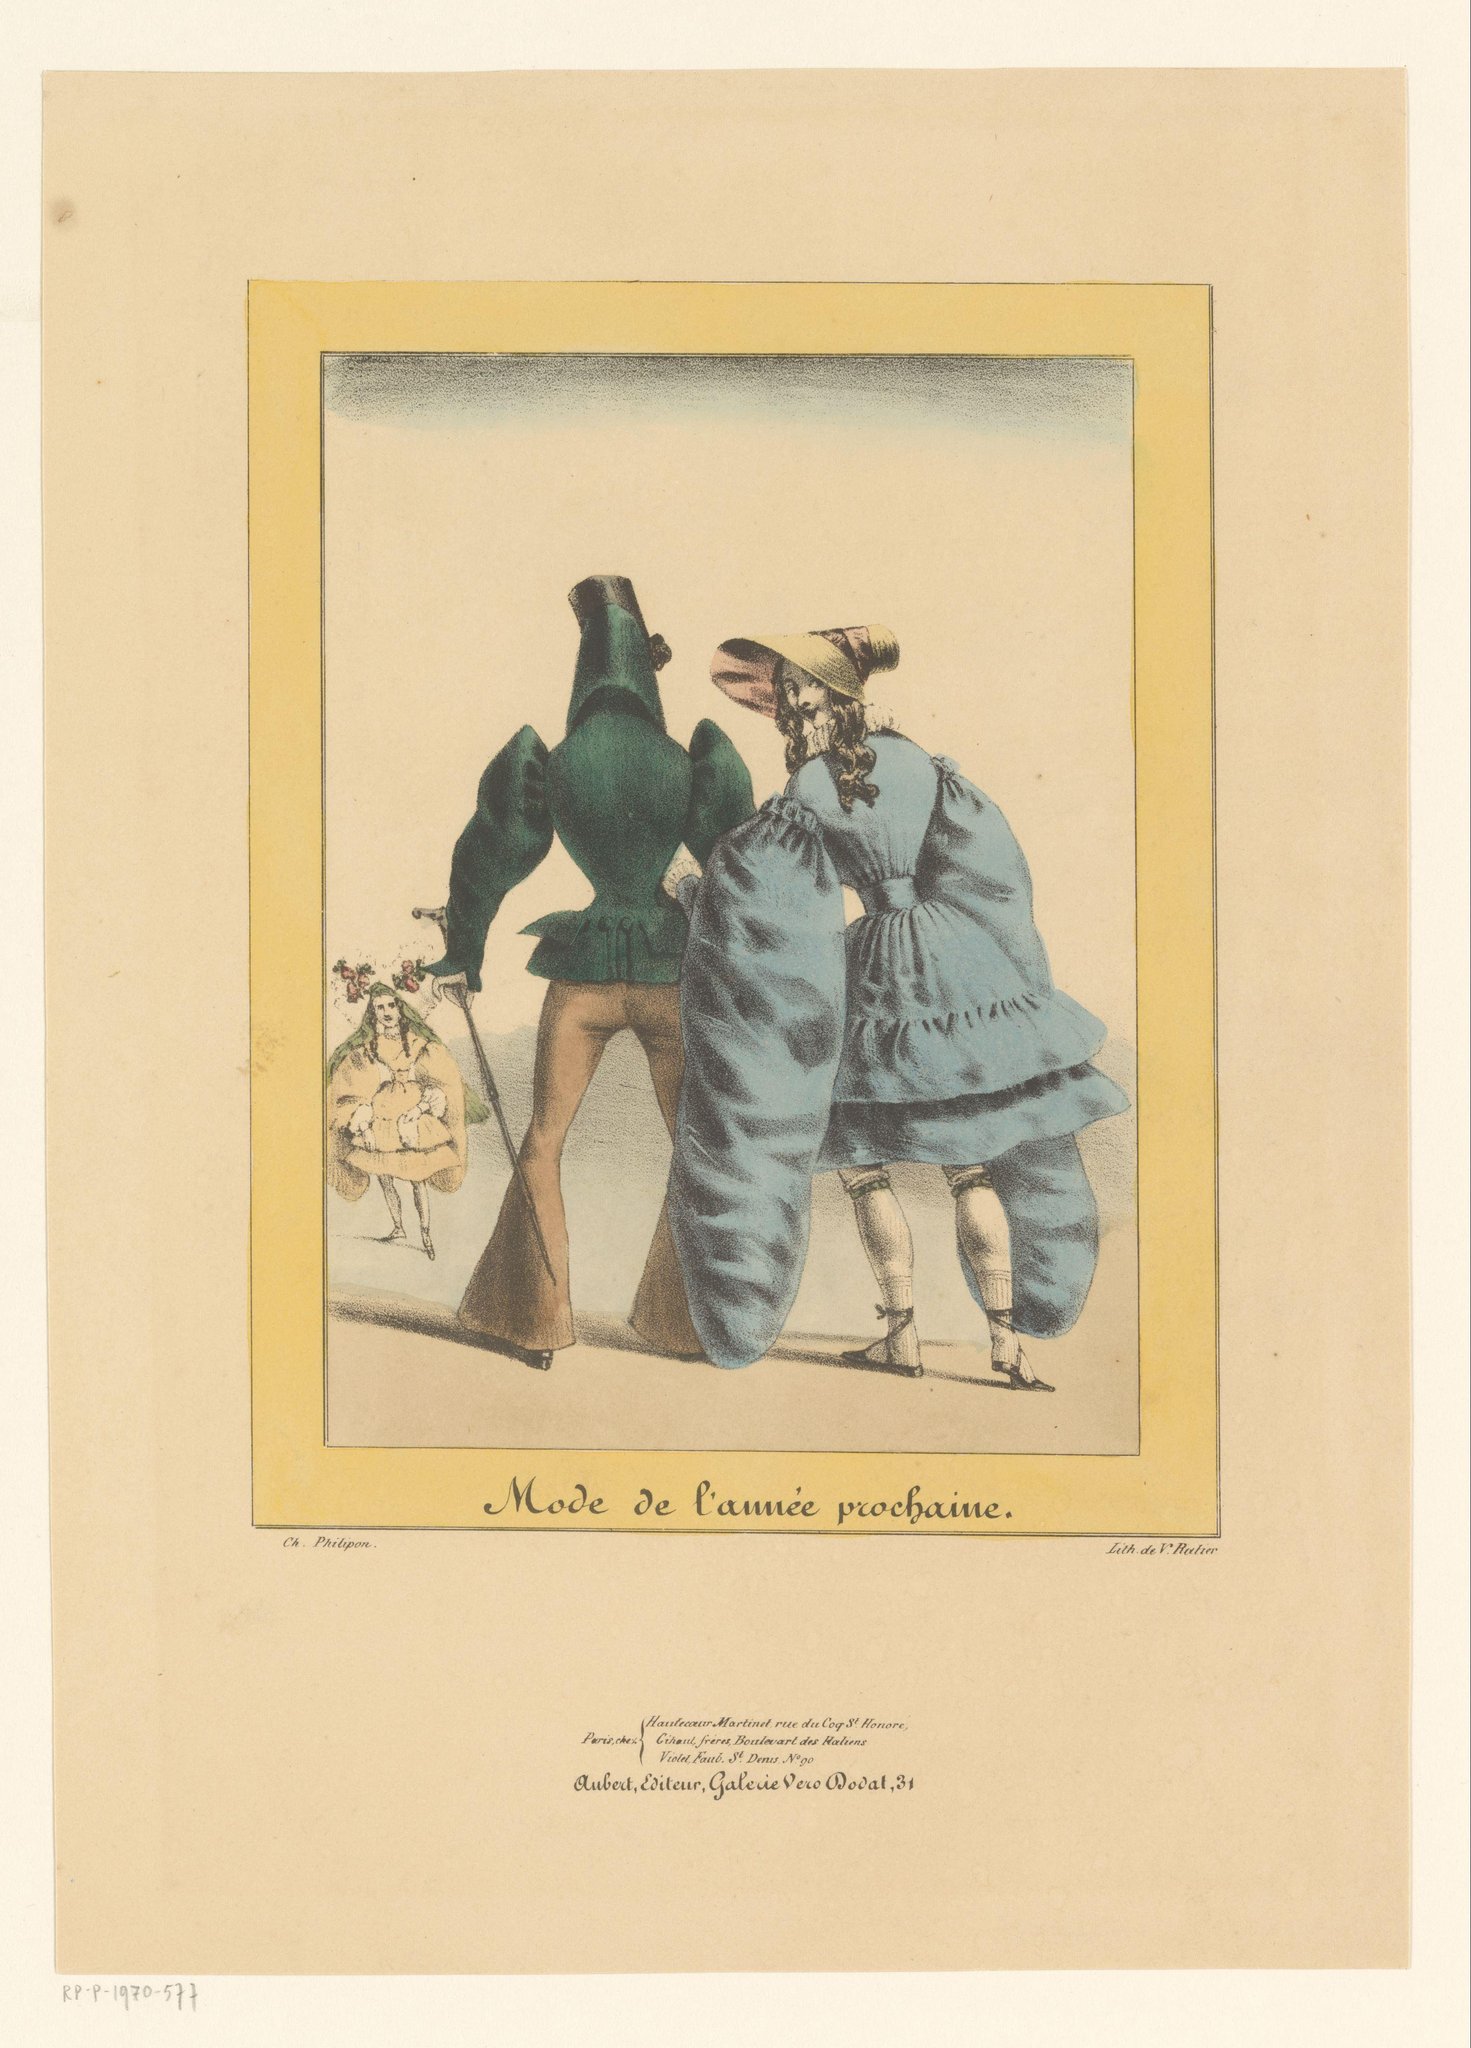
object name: print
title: Mode de l'année prochaine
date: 1829-1830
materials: paper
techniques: hand coloring, lithograph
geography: paris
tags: fashion, clothing, adult woman, adult man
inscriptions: collector's mark: Lugt 2228